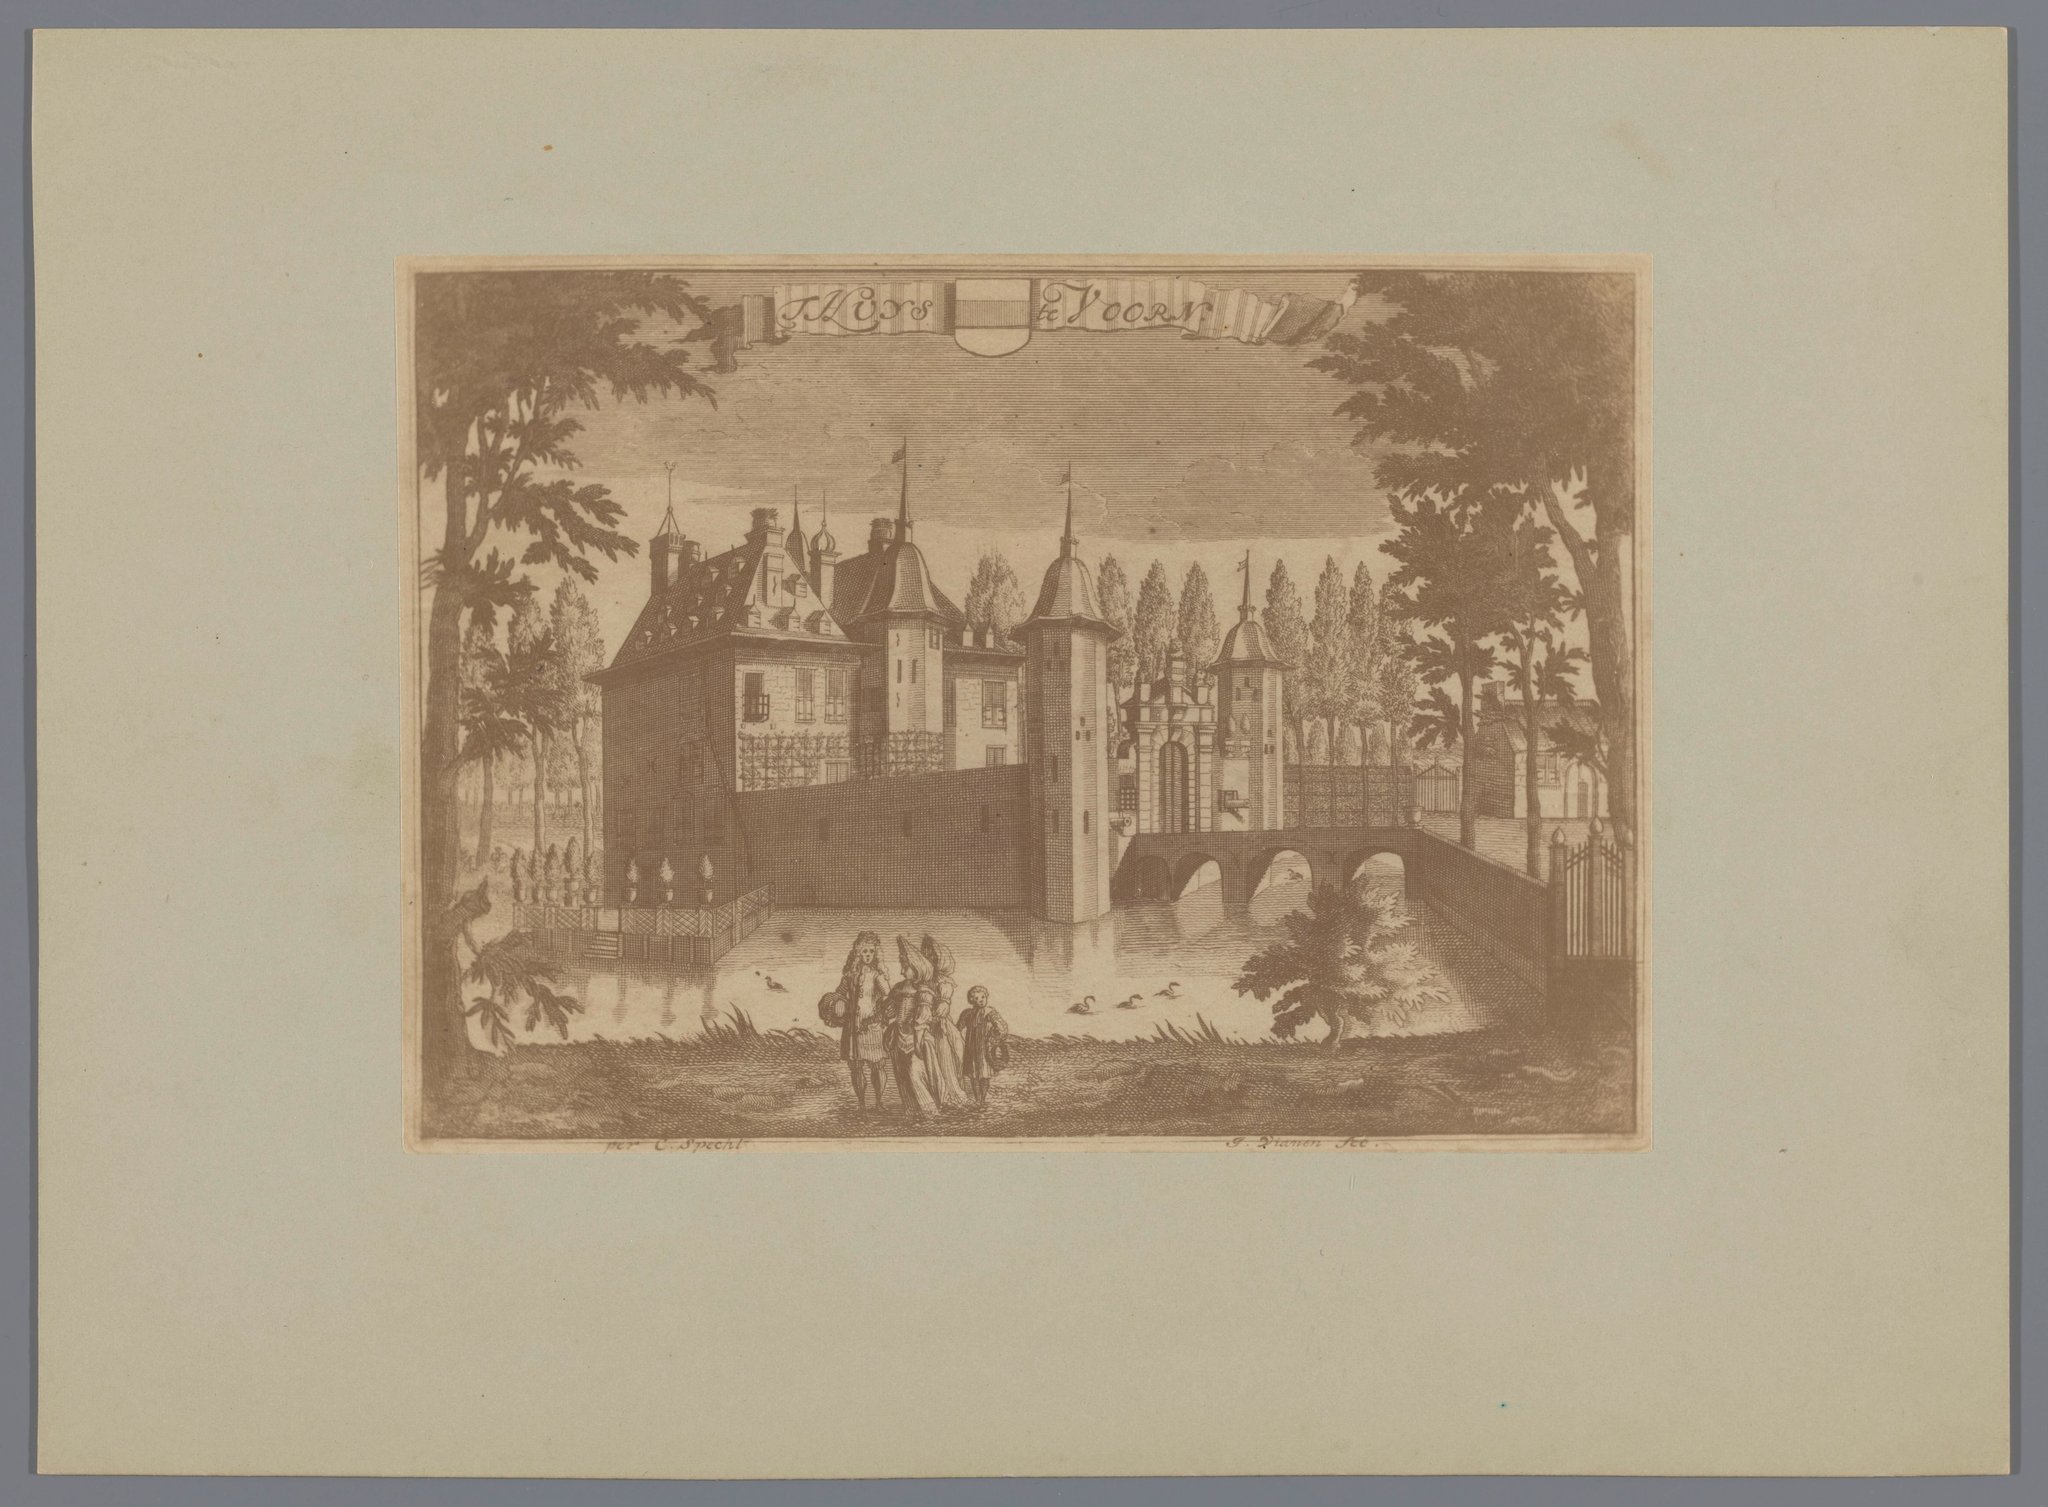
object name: photograph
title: Prent 't Huys te Voorn door J.Vianen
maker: g. a. vernout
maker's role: fotograaf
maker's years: 1848-1913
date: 1850-1880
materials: cardboard, paper, photographic support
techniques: albumen print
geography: haarlem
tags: print, e.g.: engraving, etching, lithograph, huis te voorn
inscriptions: stamp: ‘G.A. Vernout photographie Haarlem’